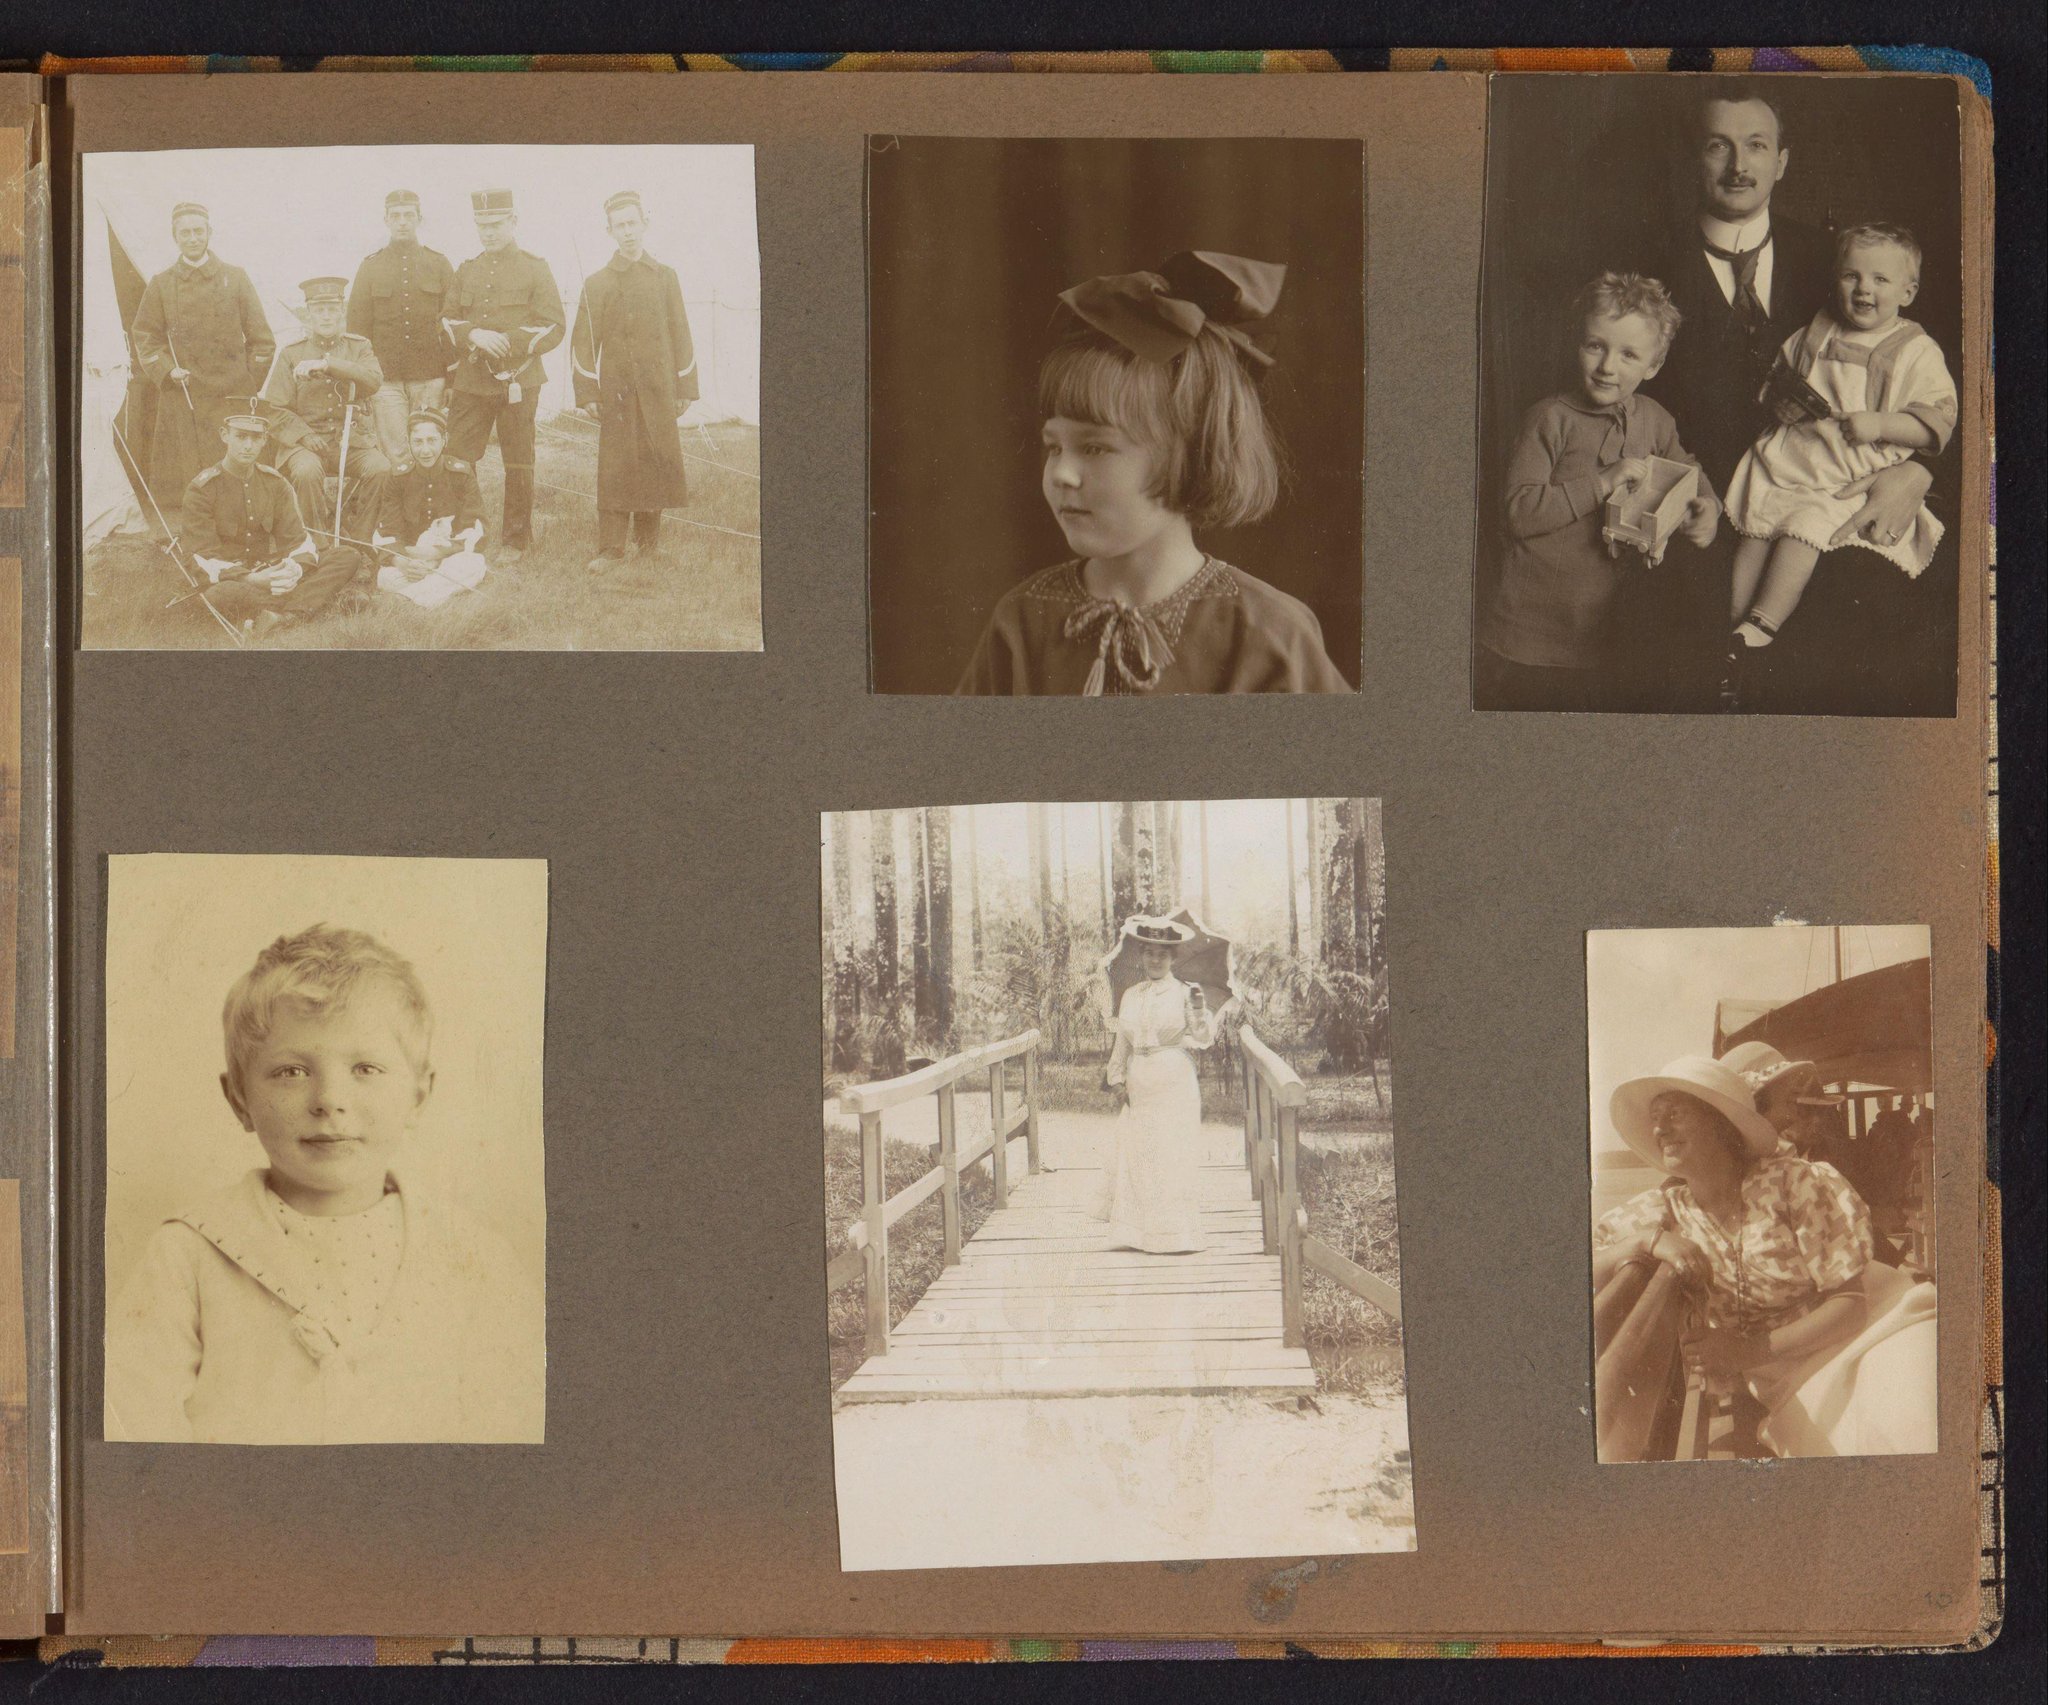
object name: photograph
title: Familiefoto's van volwassenen en kinderen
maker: Anonymous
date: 1900-1925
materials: cardboard, photographic support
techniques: gelatin silver print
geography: netherlands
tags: adult woman, child, land forces, father and child(ren), man and child(ren) (family group)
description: Albumblad met foto's van volwassenen en kinderen. Ook een foto van een groep militairen in het veld. Onderdeel van Fotoalbum van een onbekende Nederlandse familie met connecties in Suriname en Nederlands-Indië (1).